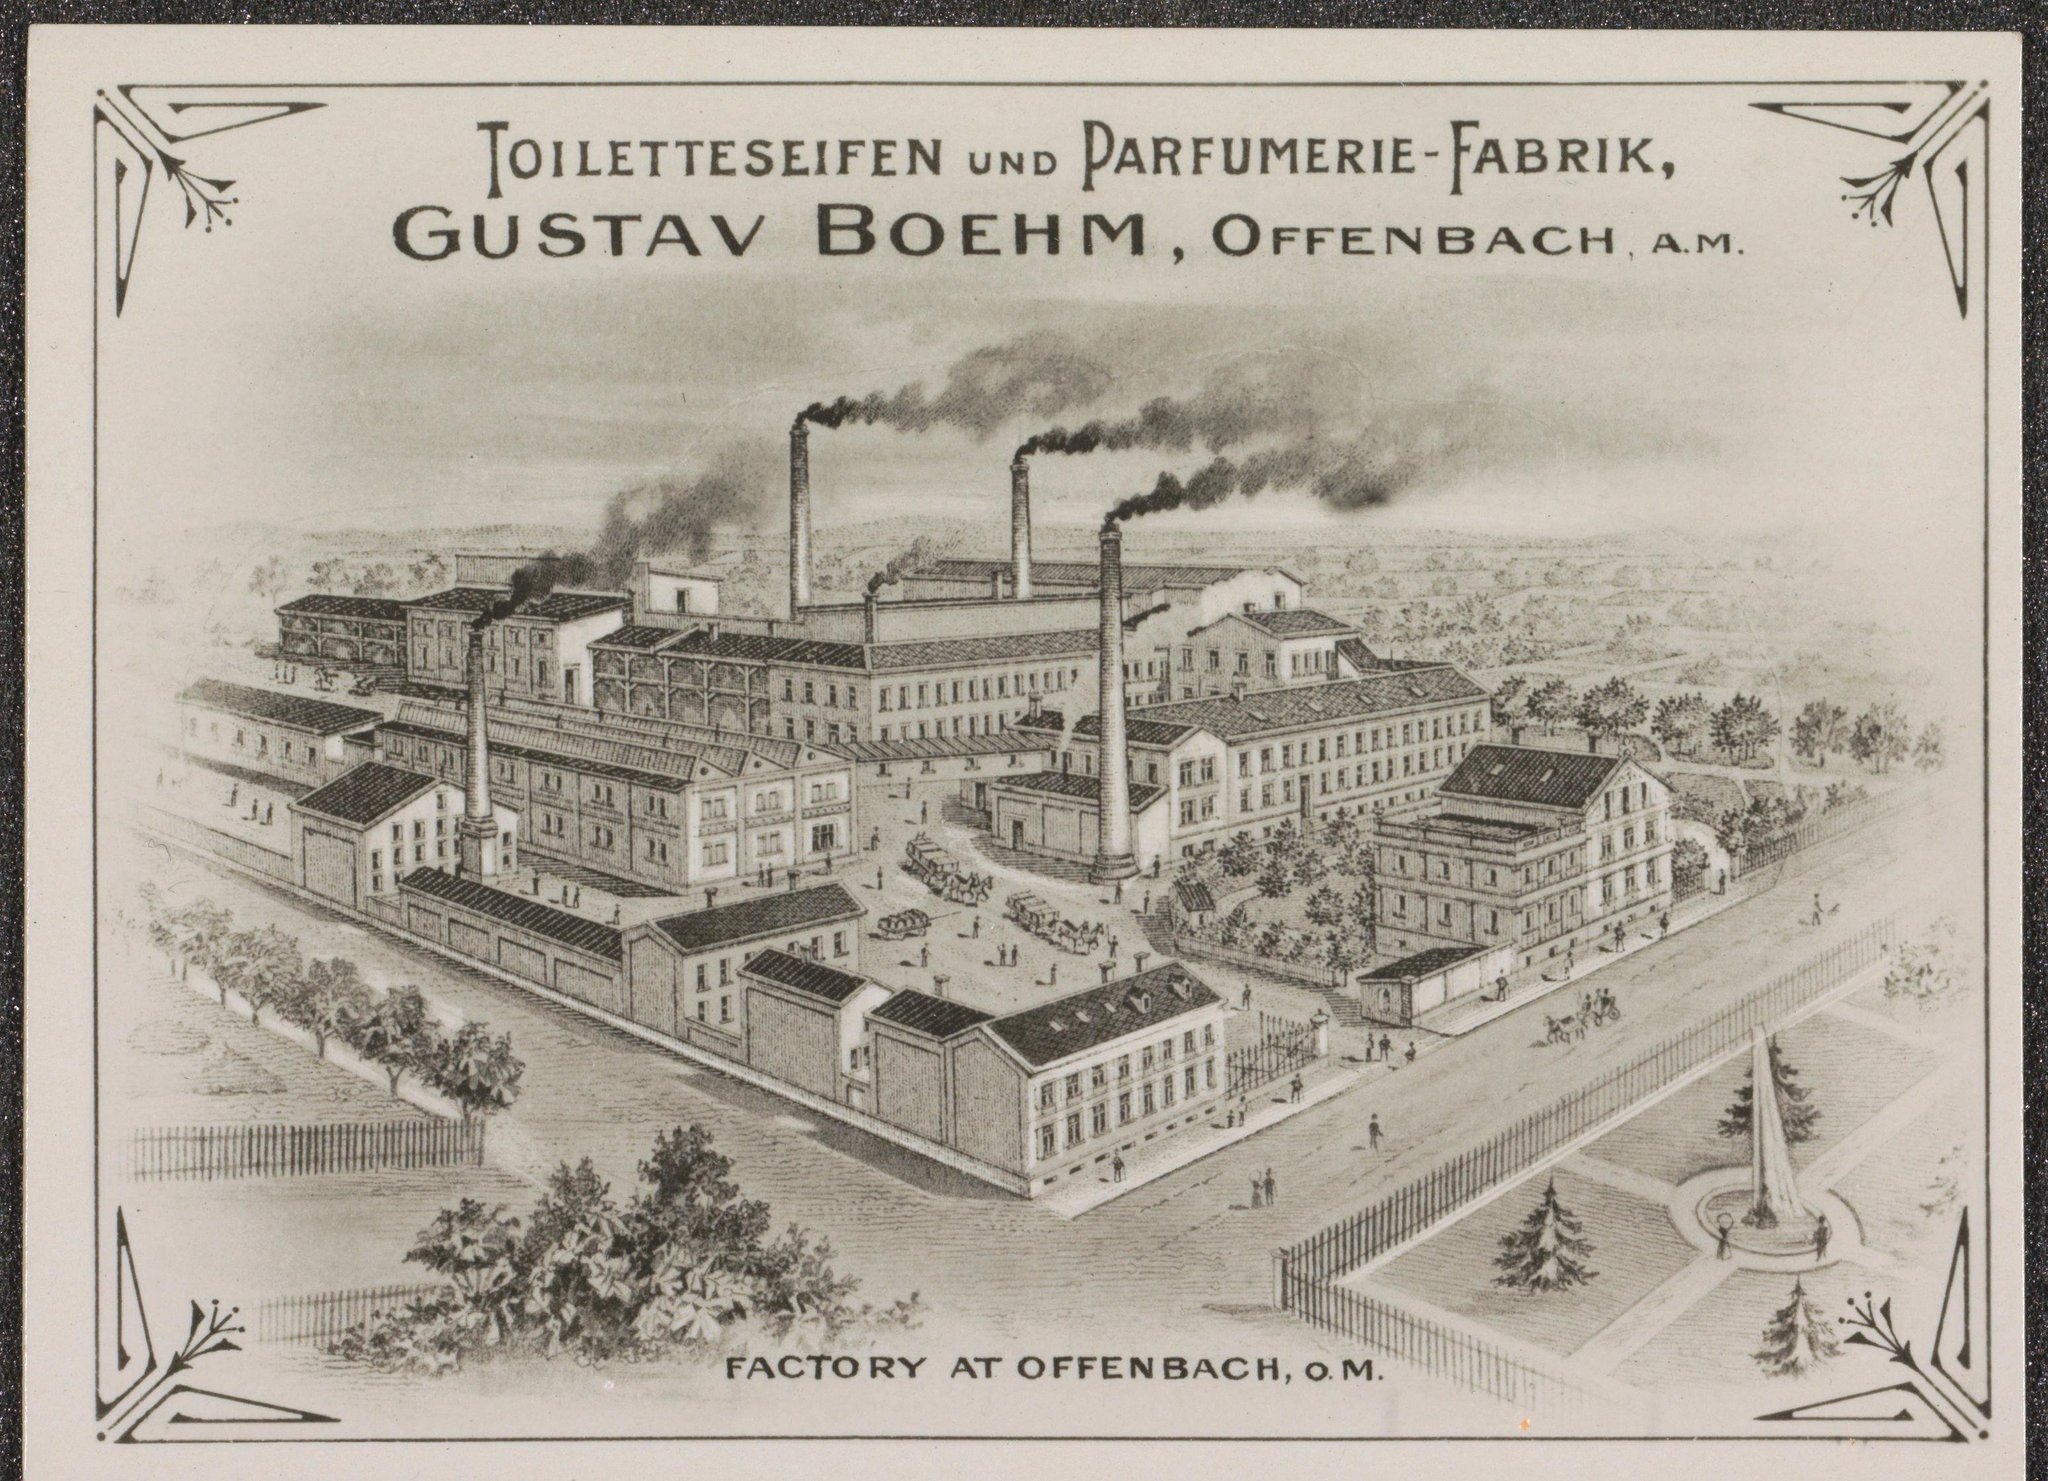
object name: photograph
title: Fotoreproductie van (vermoedelijk) een prent van de zeep- en reukwerkfabriek van Gustav Boehm in Offenbach am Main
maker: Anonymous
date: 1899-1901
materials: paper, photographic support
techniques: gelatin silver print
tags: factory-building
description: Onderdeel van Foto's van de wereldreis van Gustav Boehm 1899-1901, serie 1.